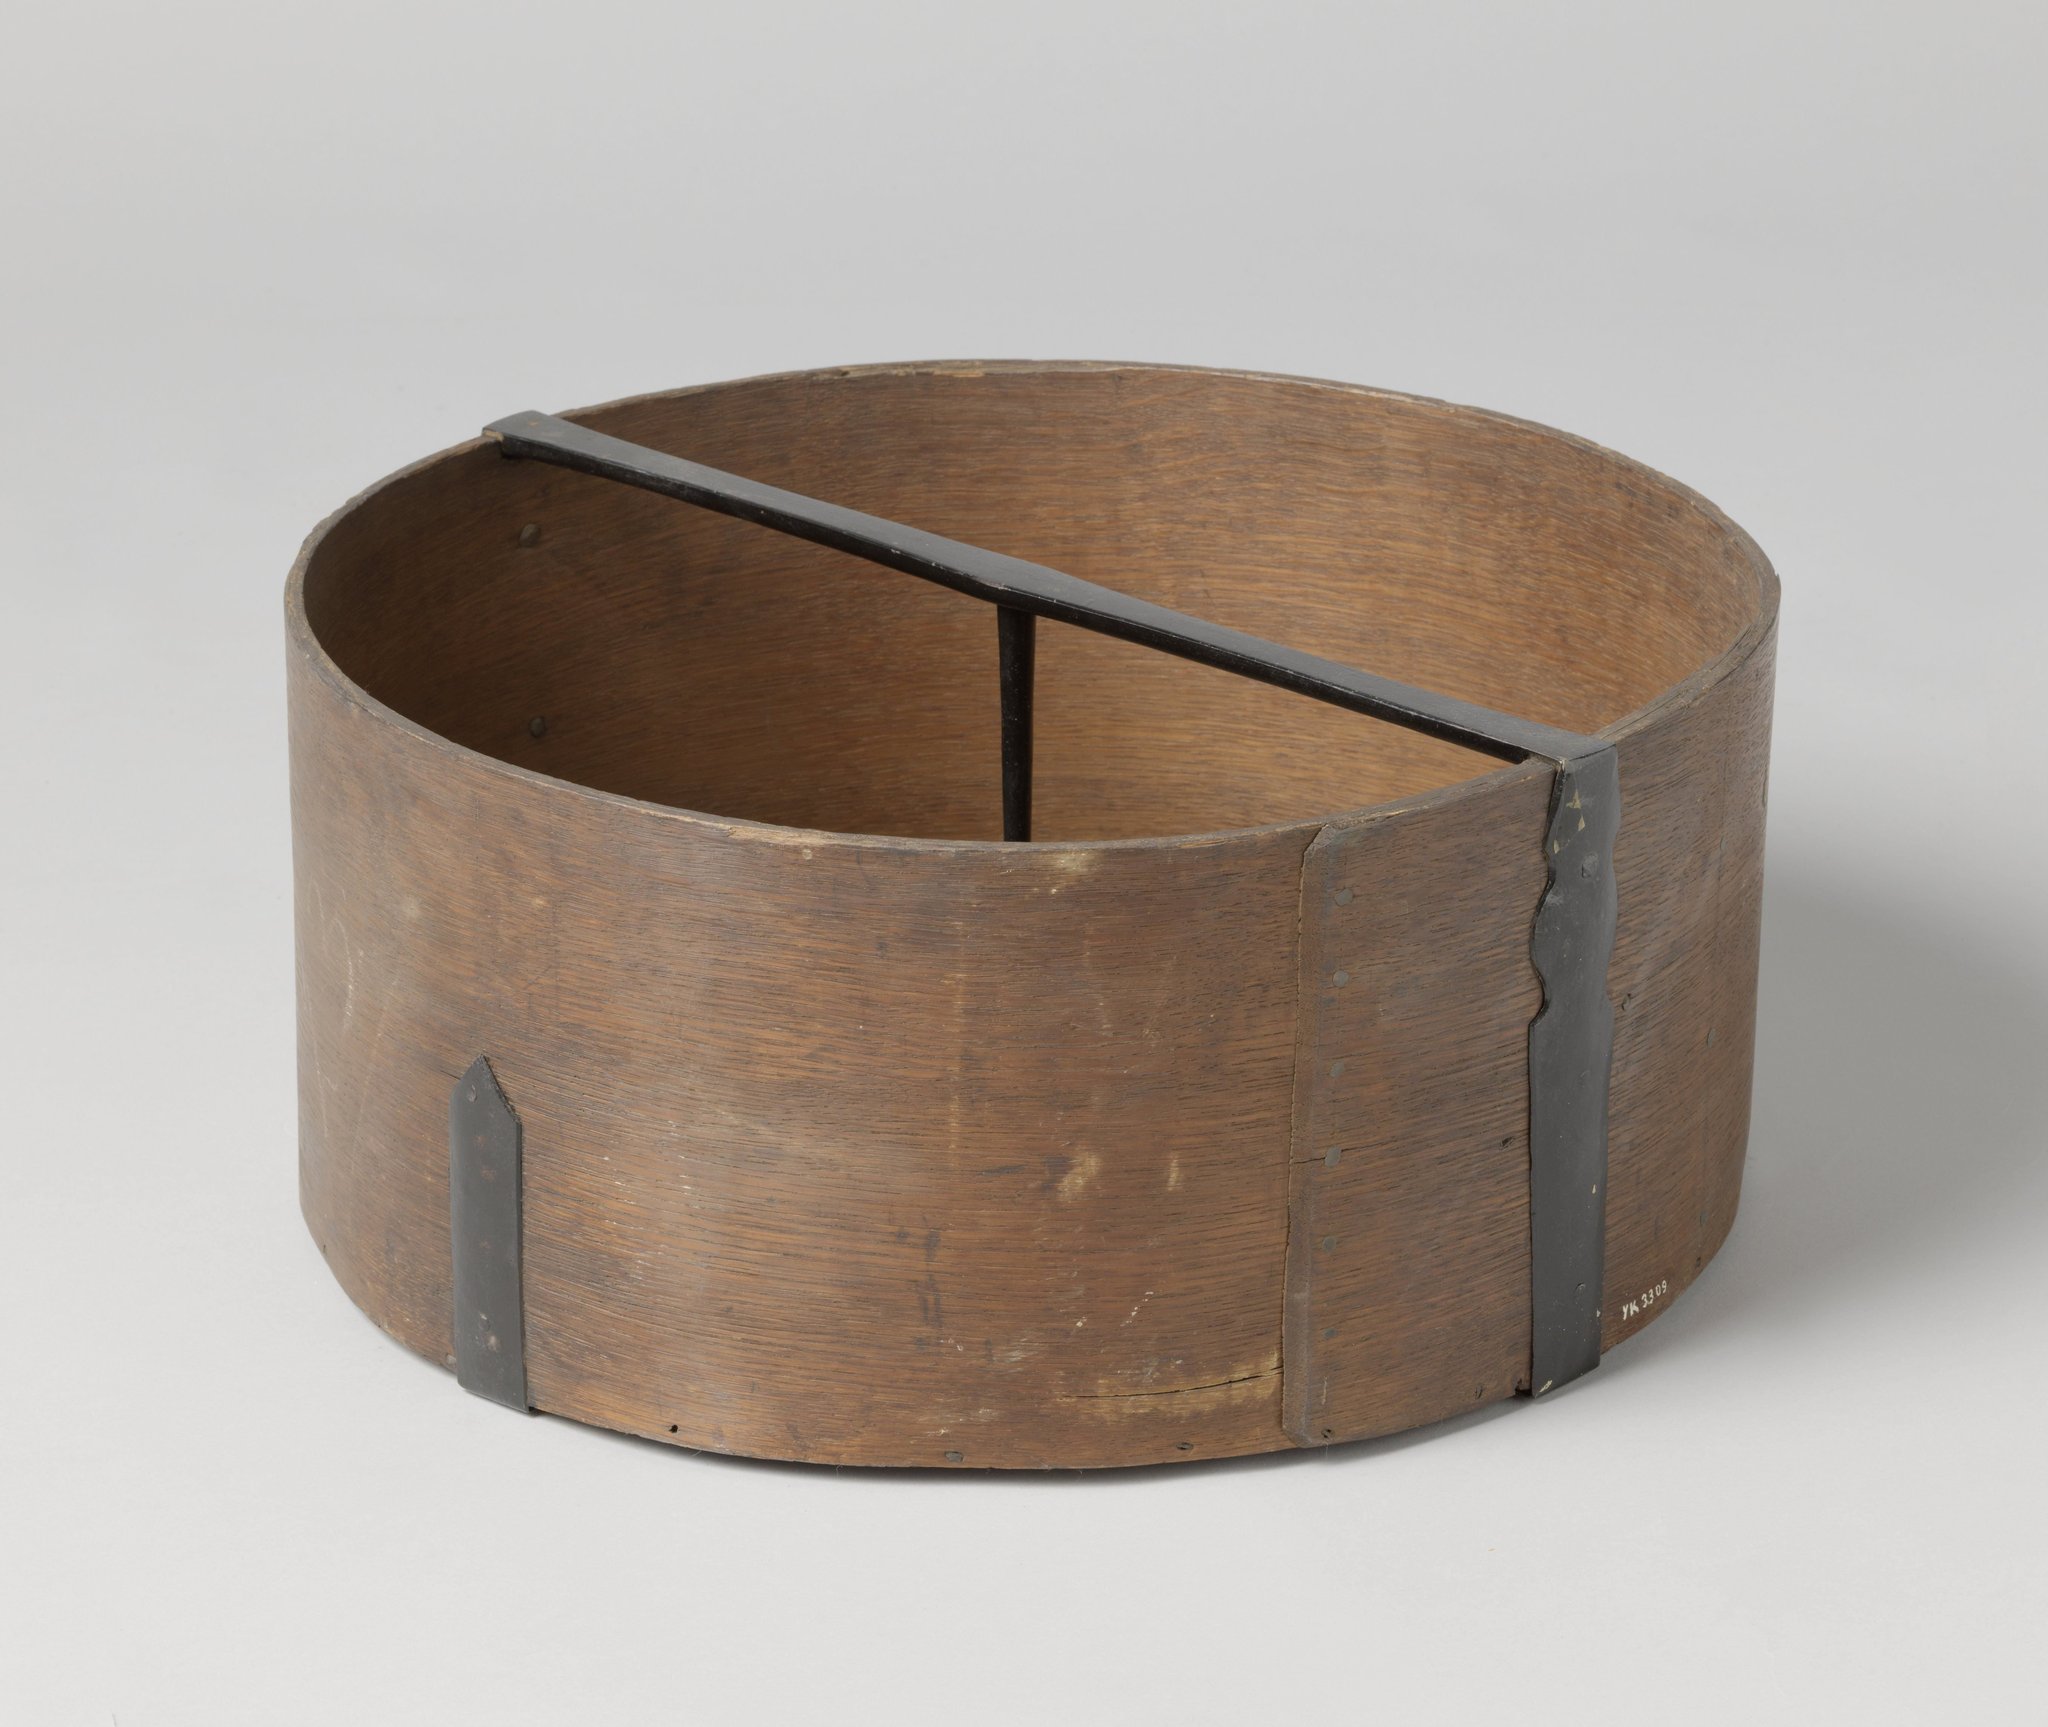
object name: inhoudsmaat droge waren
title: 1 Schepel uit Amsterdam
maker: Anonymous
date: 1800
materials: iron, wood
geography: amsterdam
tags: amsterdam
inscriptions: mark, number: ‘12’, title: ‘Amsterdam Een Schepel’, title: ‘d'Amsterdam un Boisseau’, mark: ‘XXX 1800’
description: Houten en ijzeren inhoudsmaat voor droge waren met brug en stijl van 1 schepel, v.z.v. stempel en etiketten.